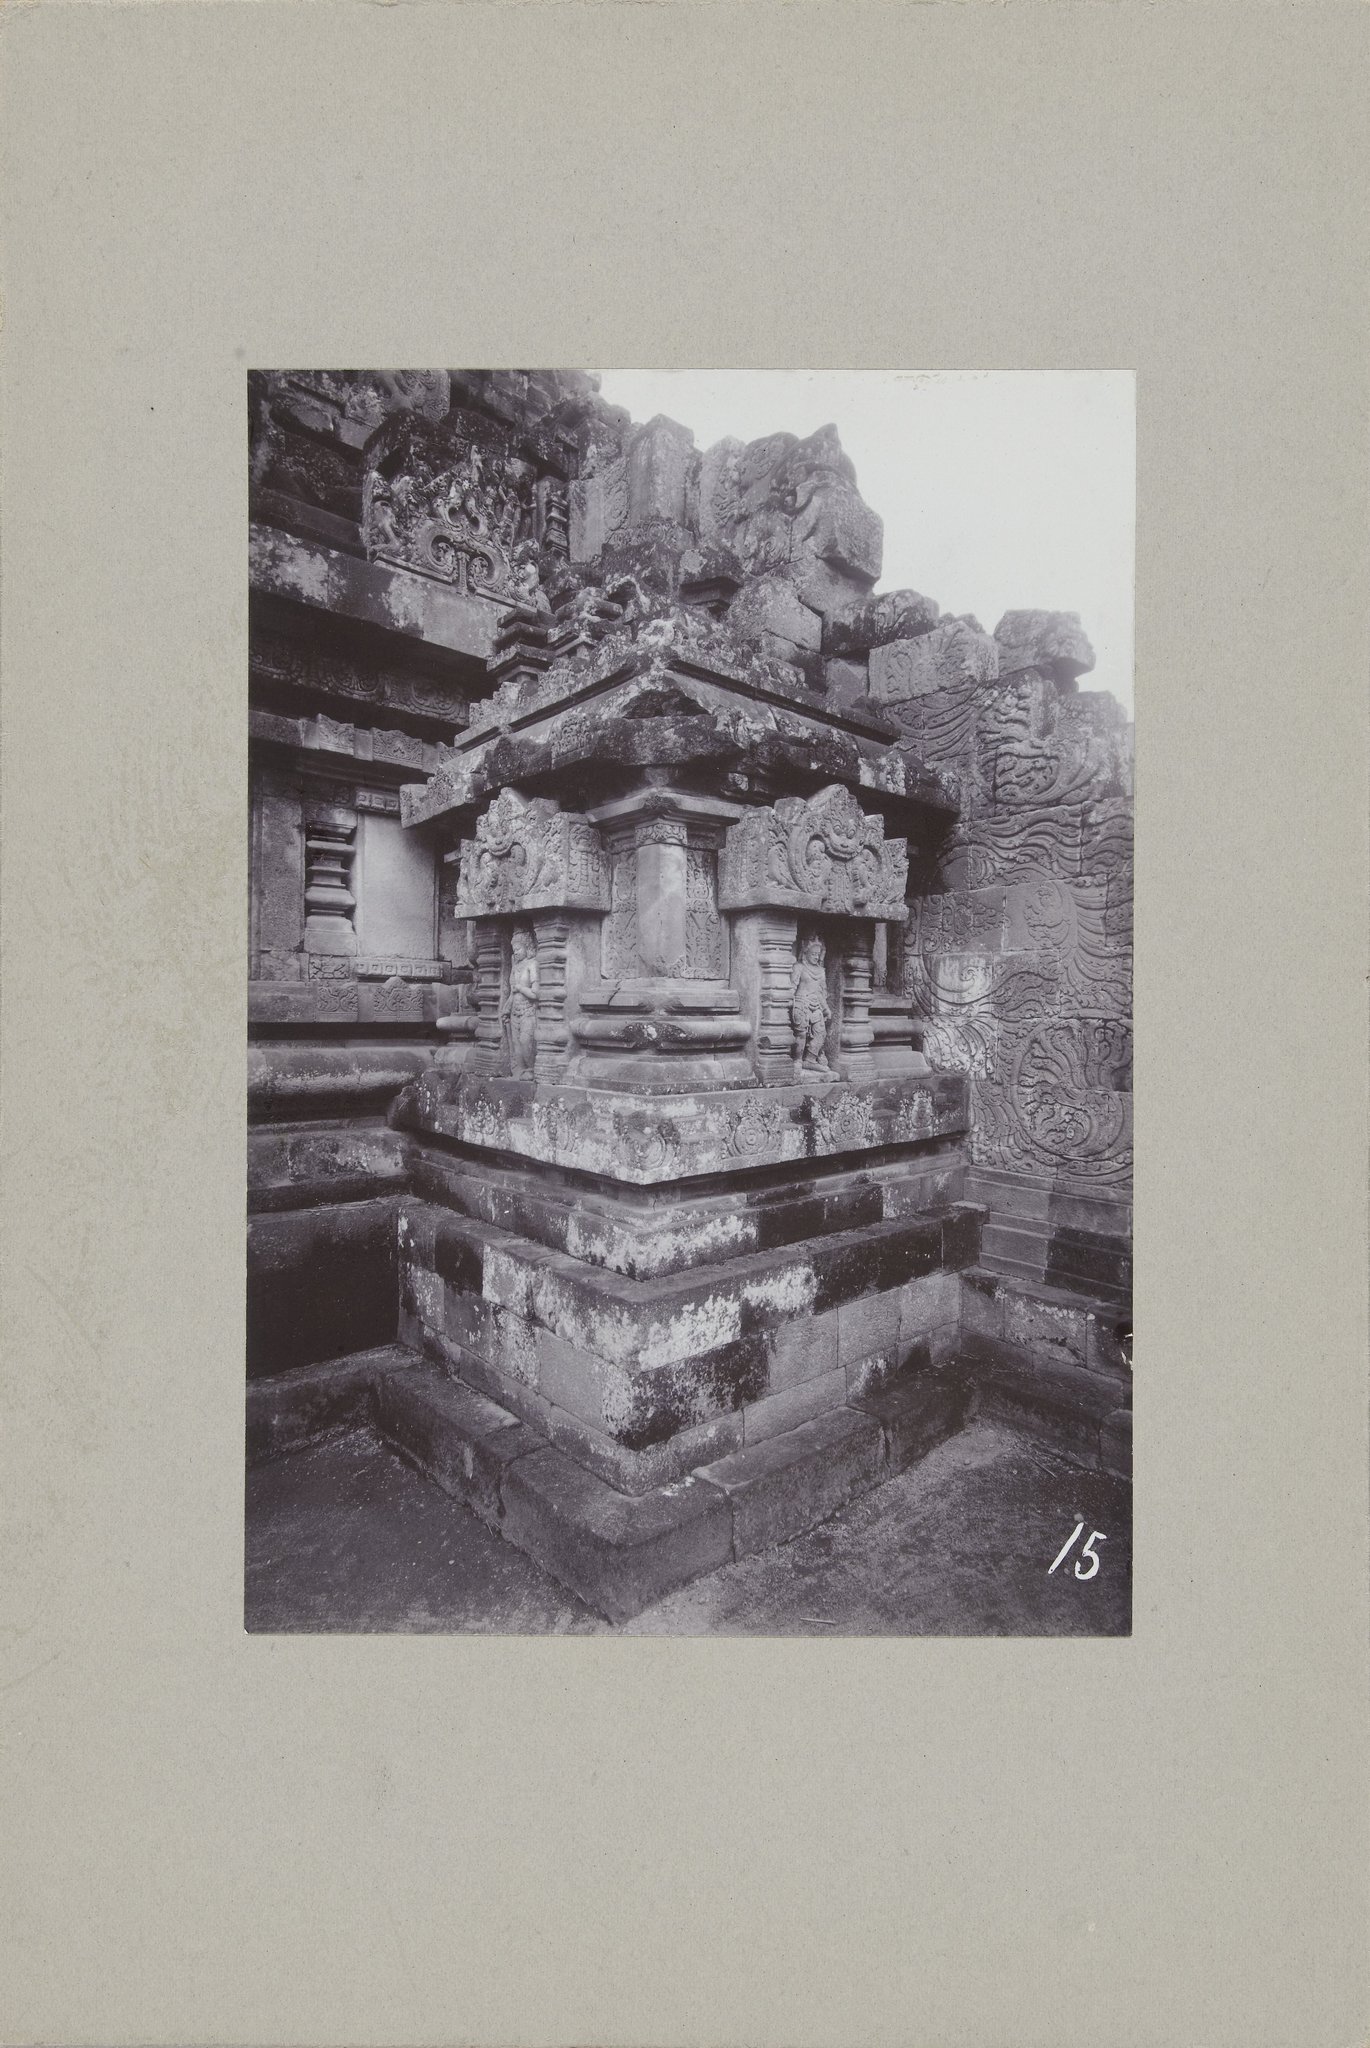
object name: photograph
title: 88a Hoekstuk van Prambanantempels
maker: Anonymous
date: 1895-1915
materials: cardboard, paper, photographic support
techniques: gelatin silver print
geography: jogjakarta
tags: indonesia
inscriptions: number: ‘15’, annotation: ‘88a Hoekstuk van Prambanantempels’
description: Hoekstuk van een tempel van Prambanan bij Jogyakarta, Nederlands-Indië